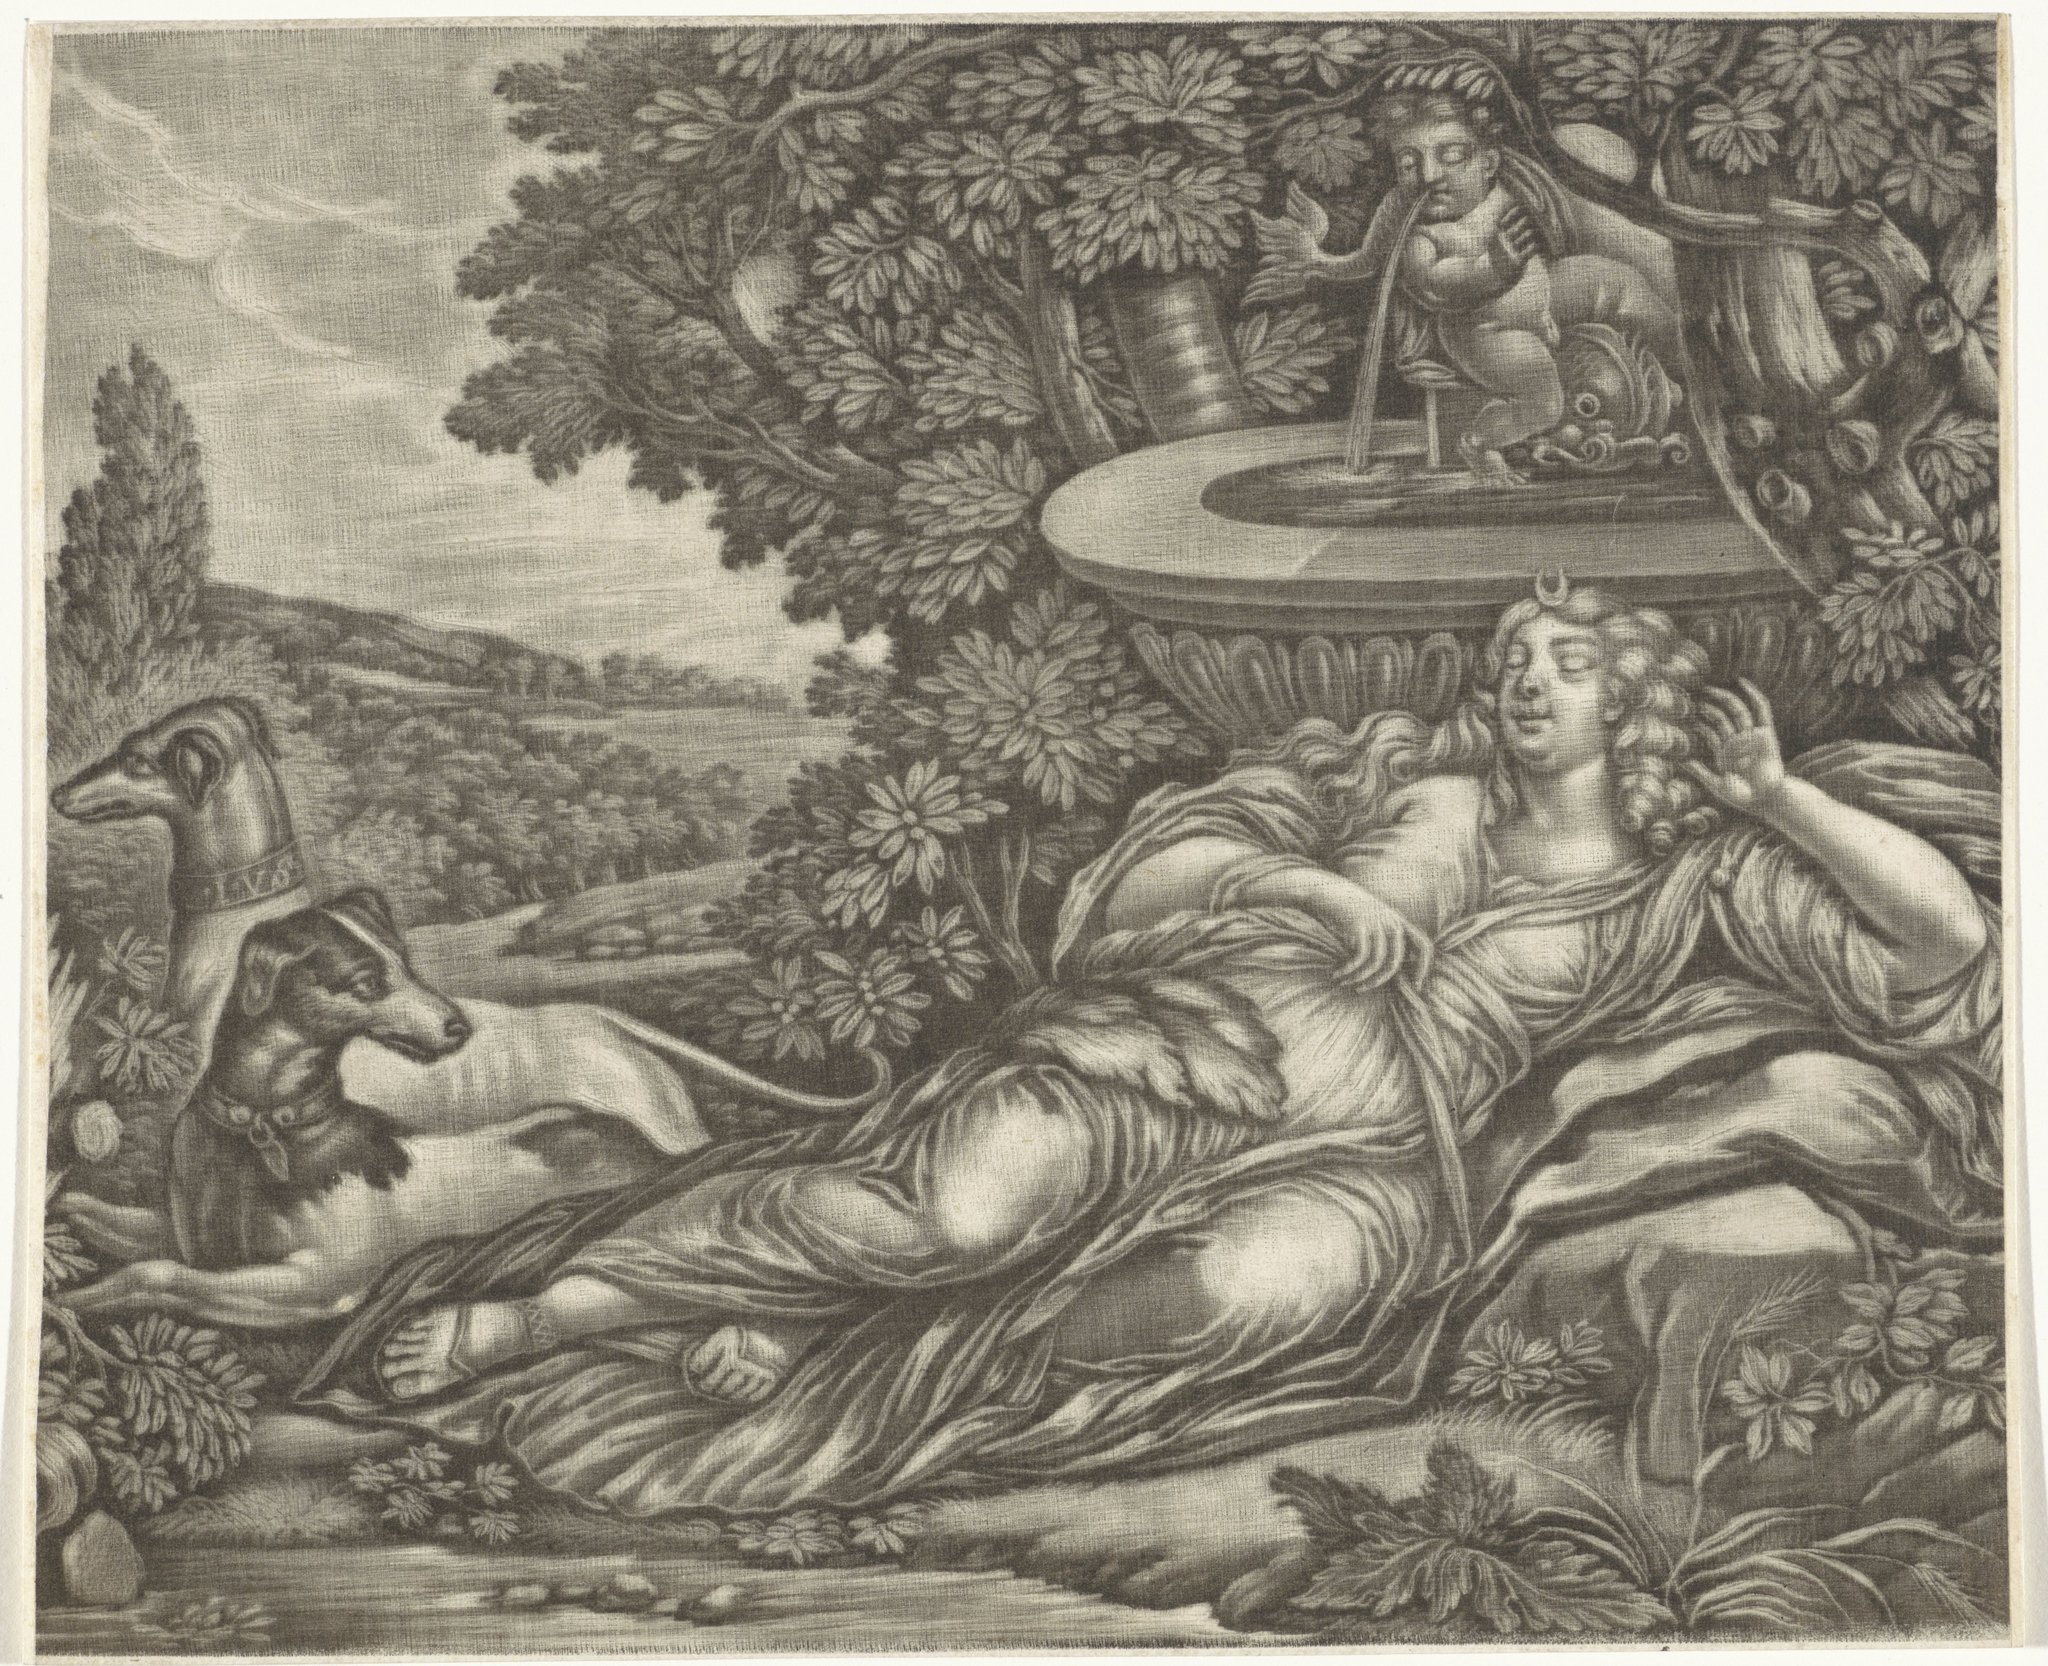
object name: print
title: Slapende Diana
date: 1659-1740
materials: paper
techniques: mezzotint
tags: (story of) diana (artemis), sleeping; unconsciousness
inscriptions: collector's mark: Lugt 2228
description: In een landschap ligt Diana te slapen bij een fontein. Aan haar voeten liggen twee jachthonden.